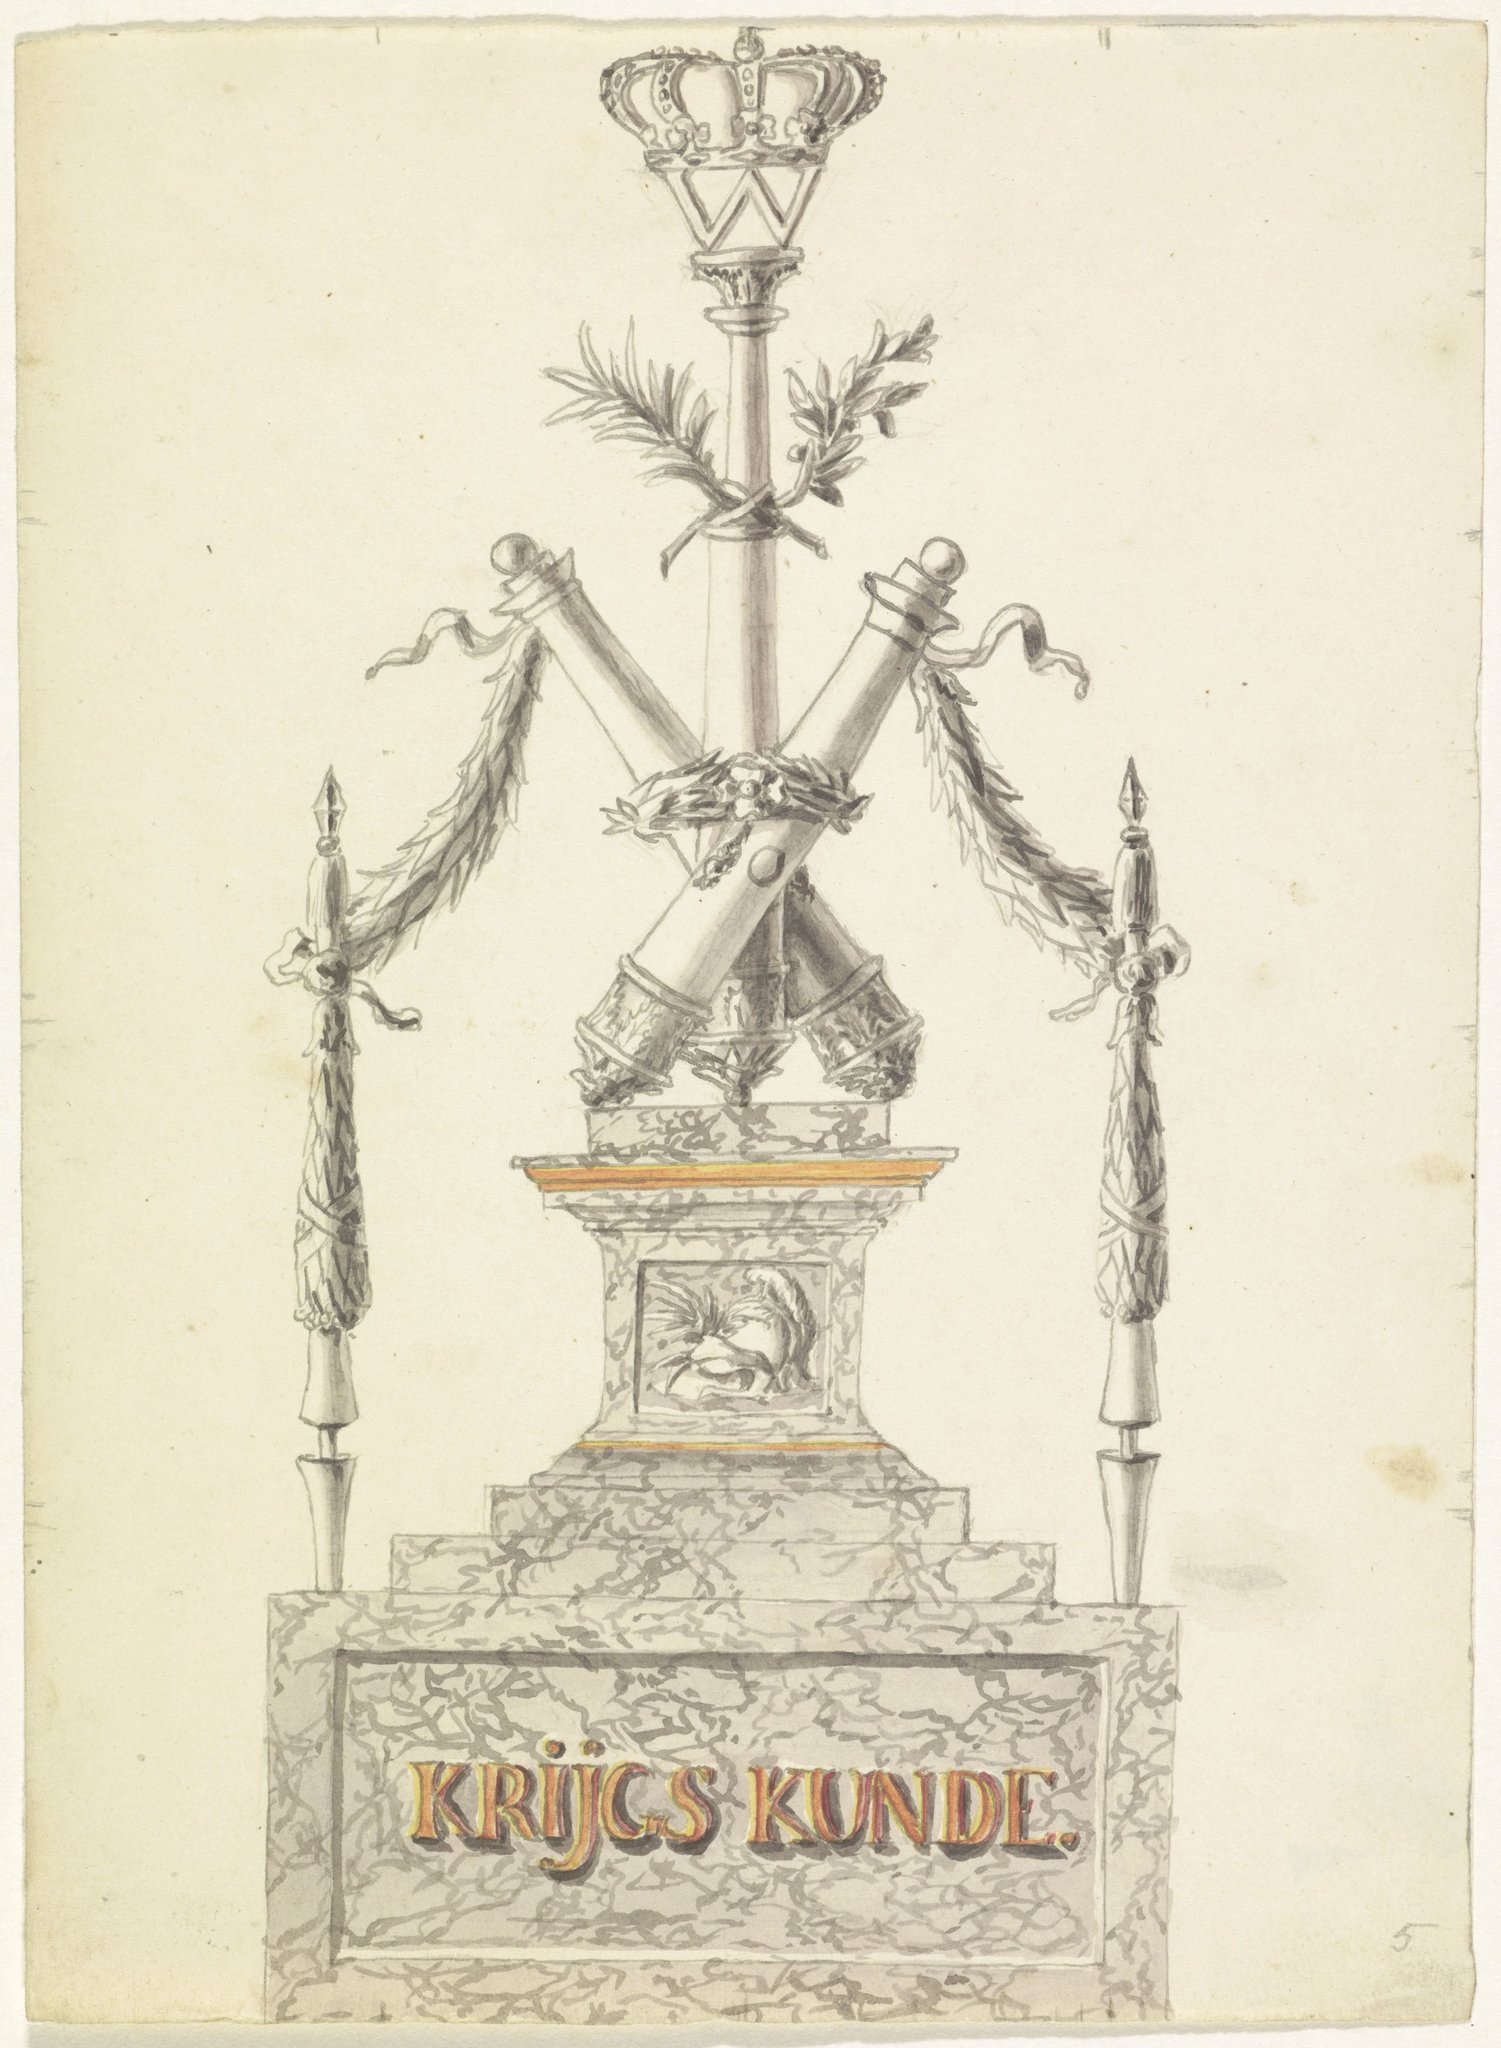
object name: drawing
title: Decoratie op de Keizersgracht bij de Leidsestraat, 1816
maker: Anonymous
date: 1816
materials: paper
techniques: brush, pen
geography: netherlands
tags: the hague, anna paulowna romanowa, william ii of the netherlands, 'tropaion', i.e. decorative ornament ~ weapons, public festivities on the occasion of royal events (+ decorated staff, portable structure ~ festive activities), symbols, allegories of war; 'guerra' (ripa), other decorative structures (~ triumphal entry, etc.), amsterdam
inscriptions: collector's mark: Lugt 2228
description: Decoratie met het thema Krijgskunde. Trofee met een kanonnen en bovenop een gekroonde W. Op de sokkel 'Krijgs Kunde'. Opgericht op de Keizersgracht bij de sluis met de Leidsestraat. Onderdeel van een serie van 14 (van de 16) tekeningen voor de decoraties opgesteld bij het bezoek van de prins en prinses van Oranje aan Amsterdam op 19 september 1816.